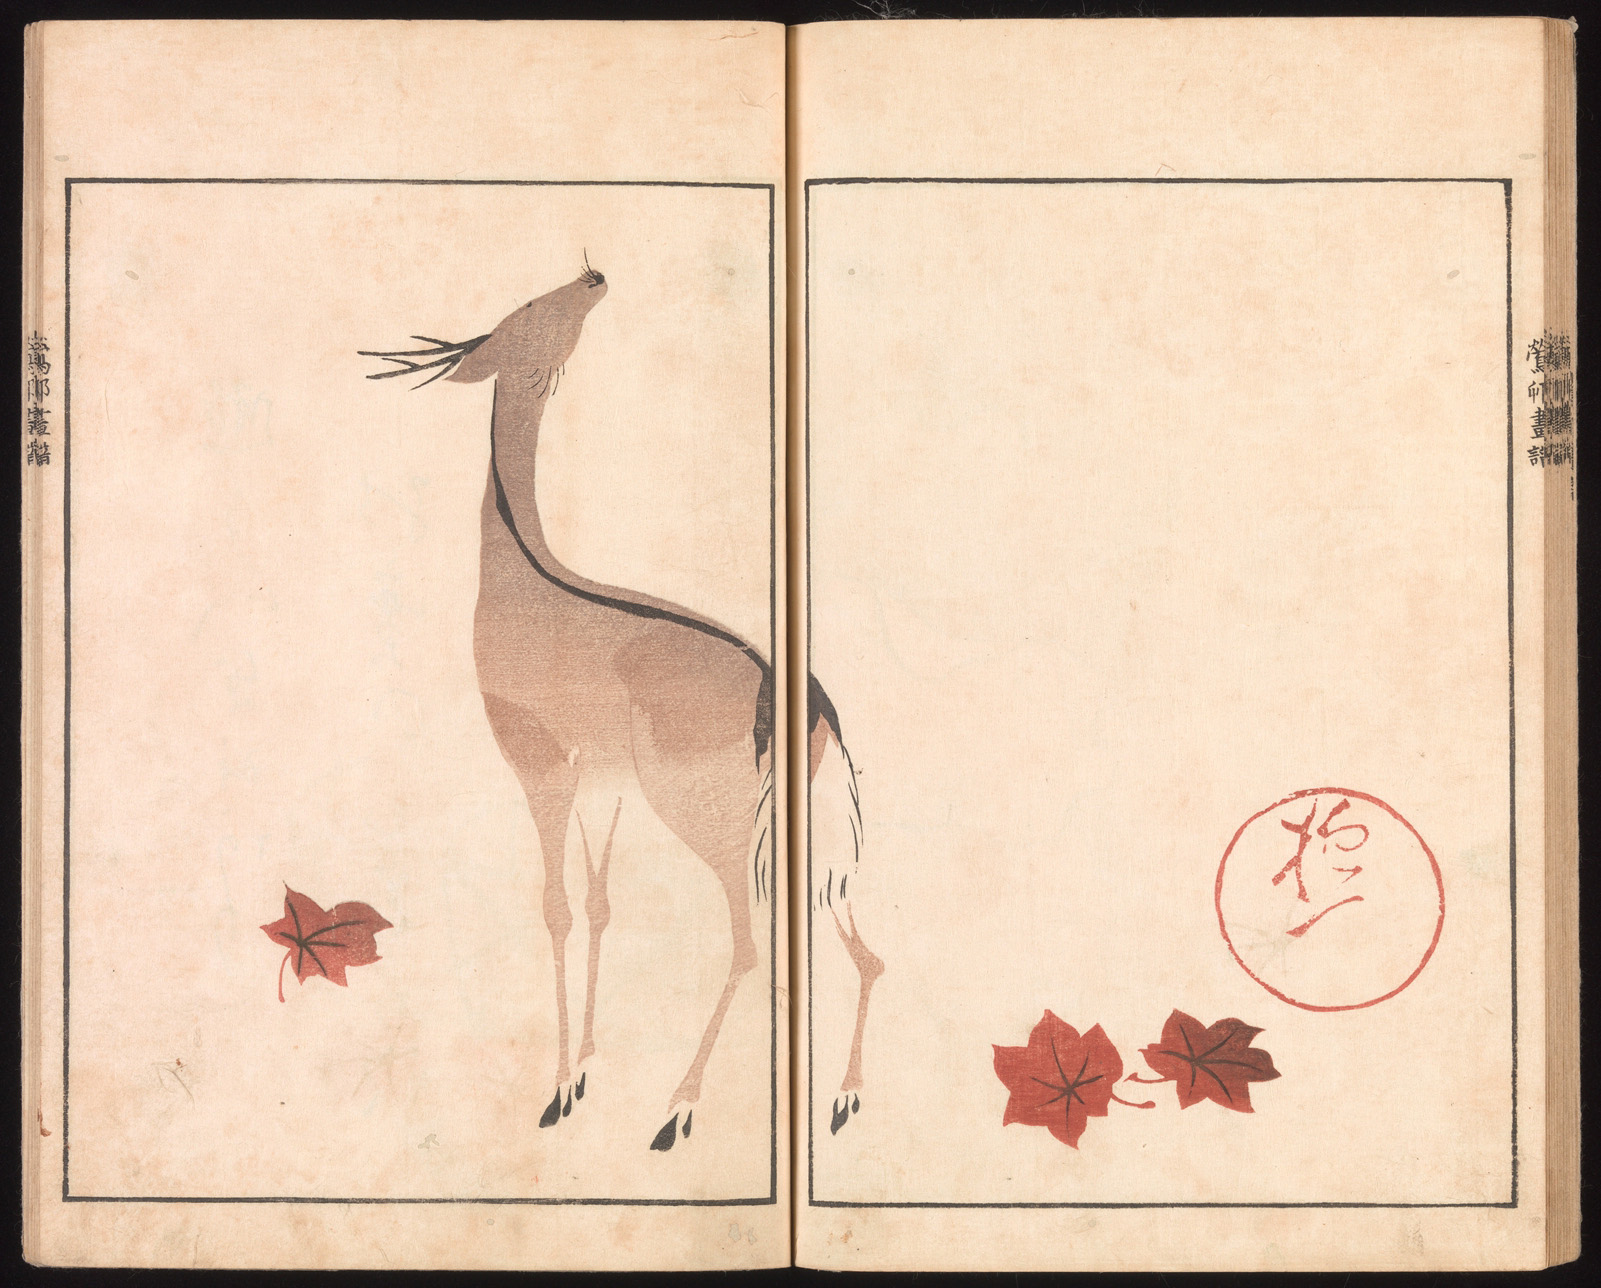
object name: illustrated book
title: Ōson (Hōitsu) Picture Album (Ōson gafu)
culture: japanese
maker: sakai hōitsu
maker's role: artist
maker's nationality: japanese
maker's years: 1761-1828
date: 1817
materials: ink, paper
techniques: woodblock print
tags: deer,leaves